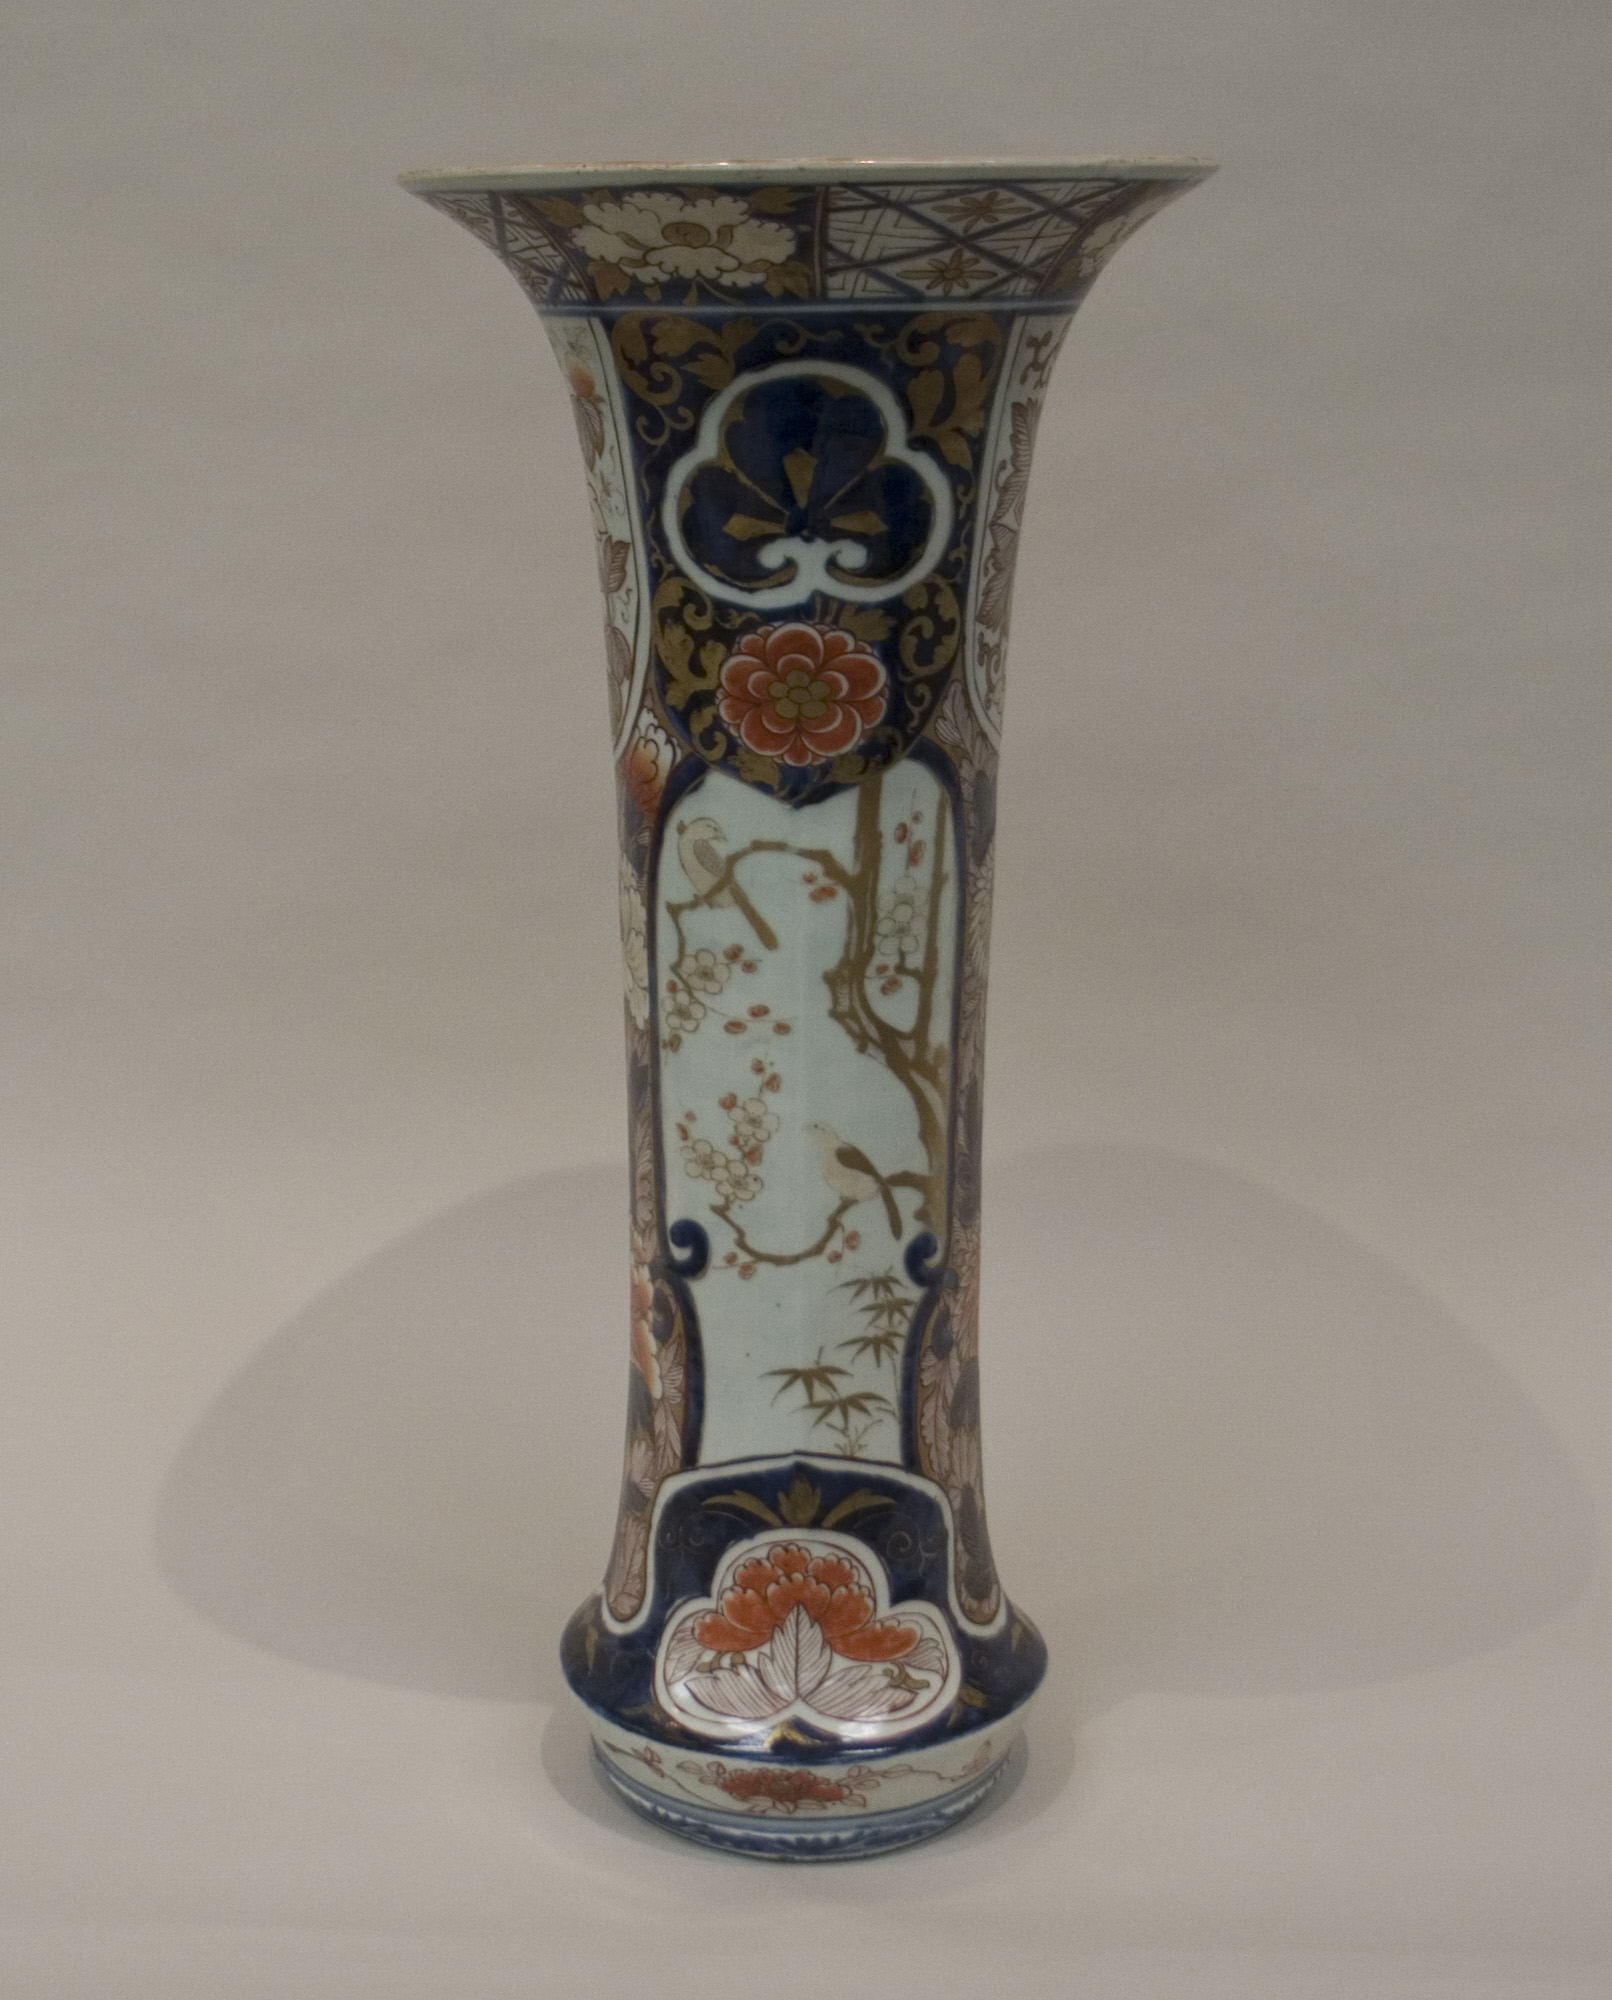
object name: vase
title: Large Vase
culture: japanese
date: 1700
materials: glaze, gold, iron, porcelain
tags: birds,flowers